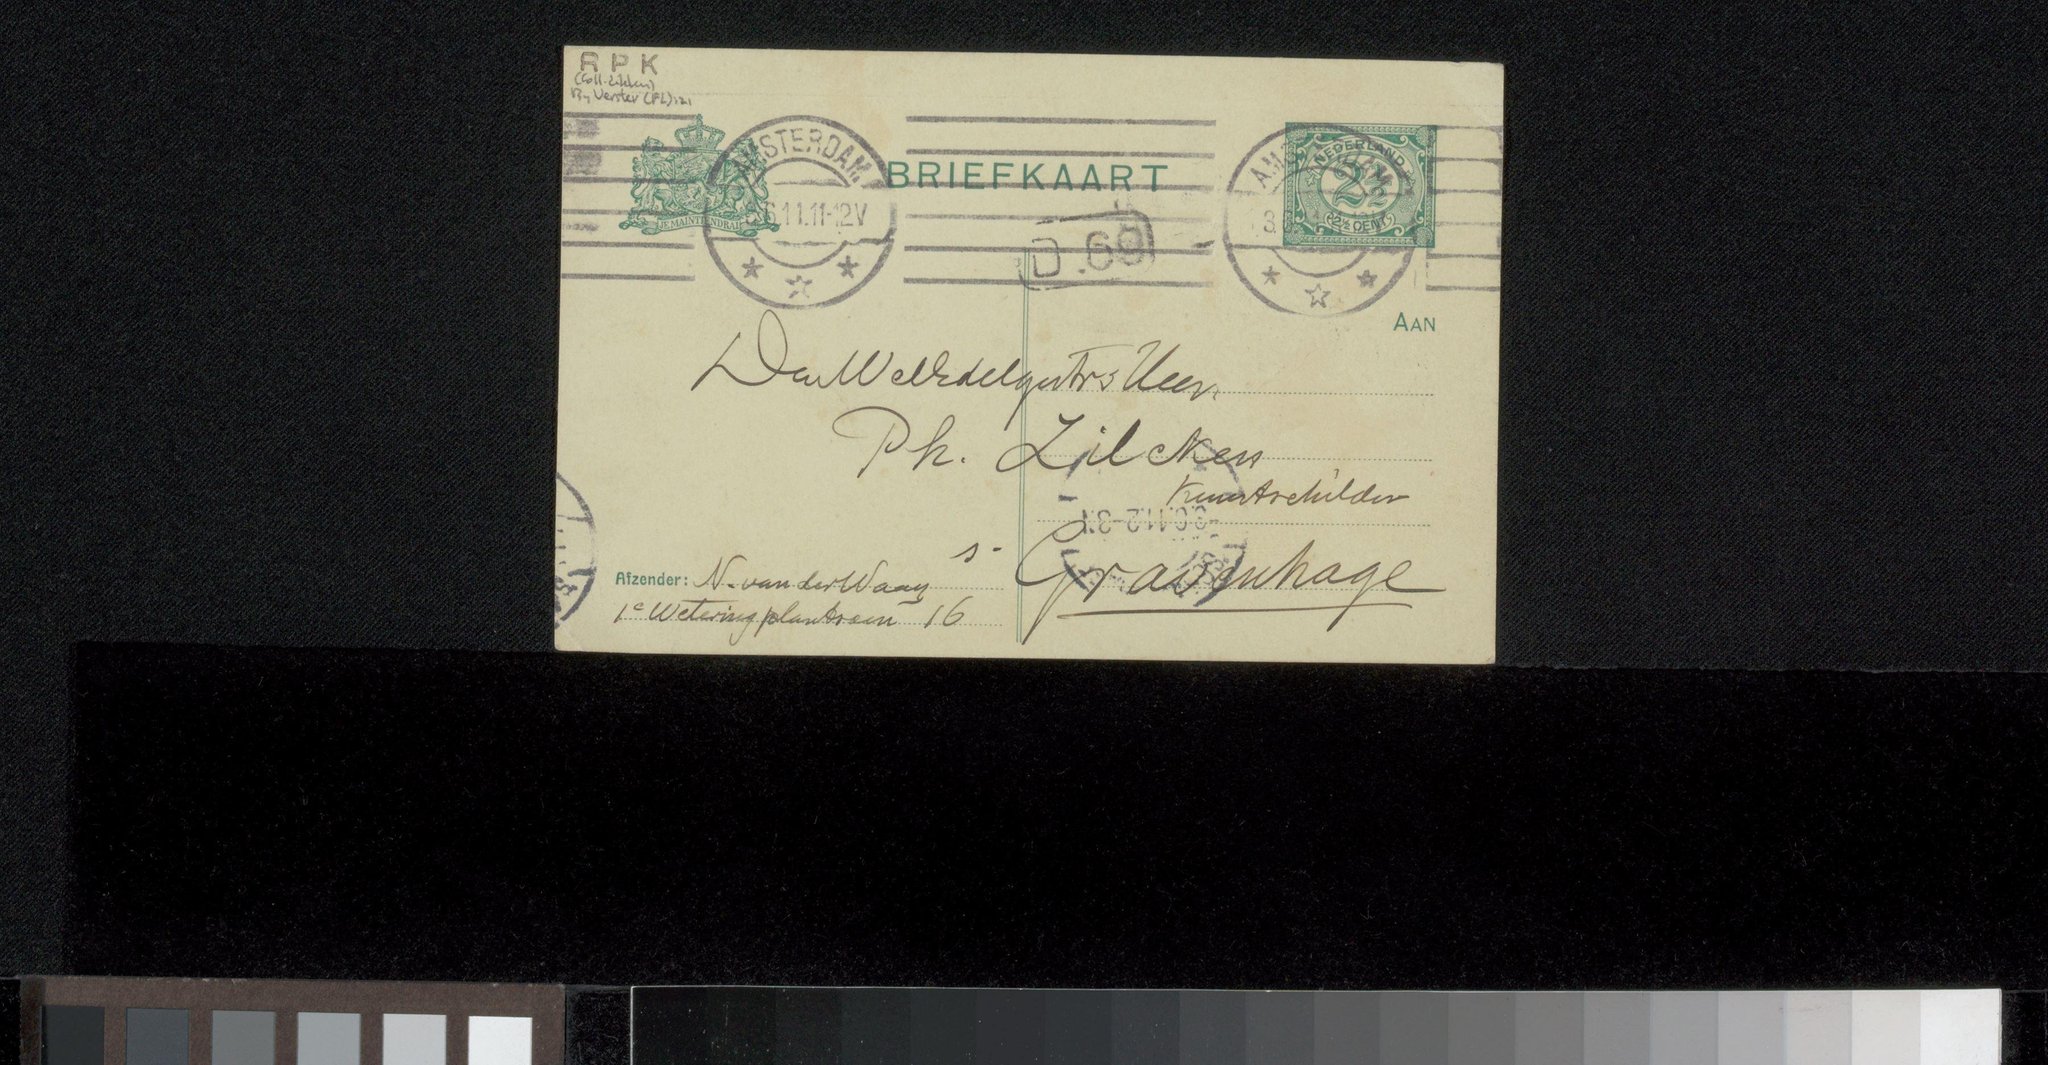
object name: postcard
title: Briefkaart aan Philip Zilcken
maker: nicolaas van der waay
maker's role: draughtsman, painter, print maker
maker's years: 1855-1936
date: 1911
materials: cardboard, ink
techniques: pen, writing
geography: amsterdam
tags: publisher, jan schüller, the hague, philip zilcken, drawing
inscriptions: collector's mark: ‘RPK’